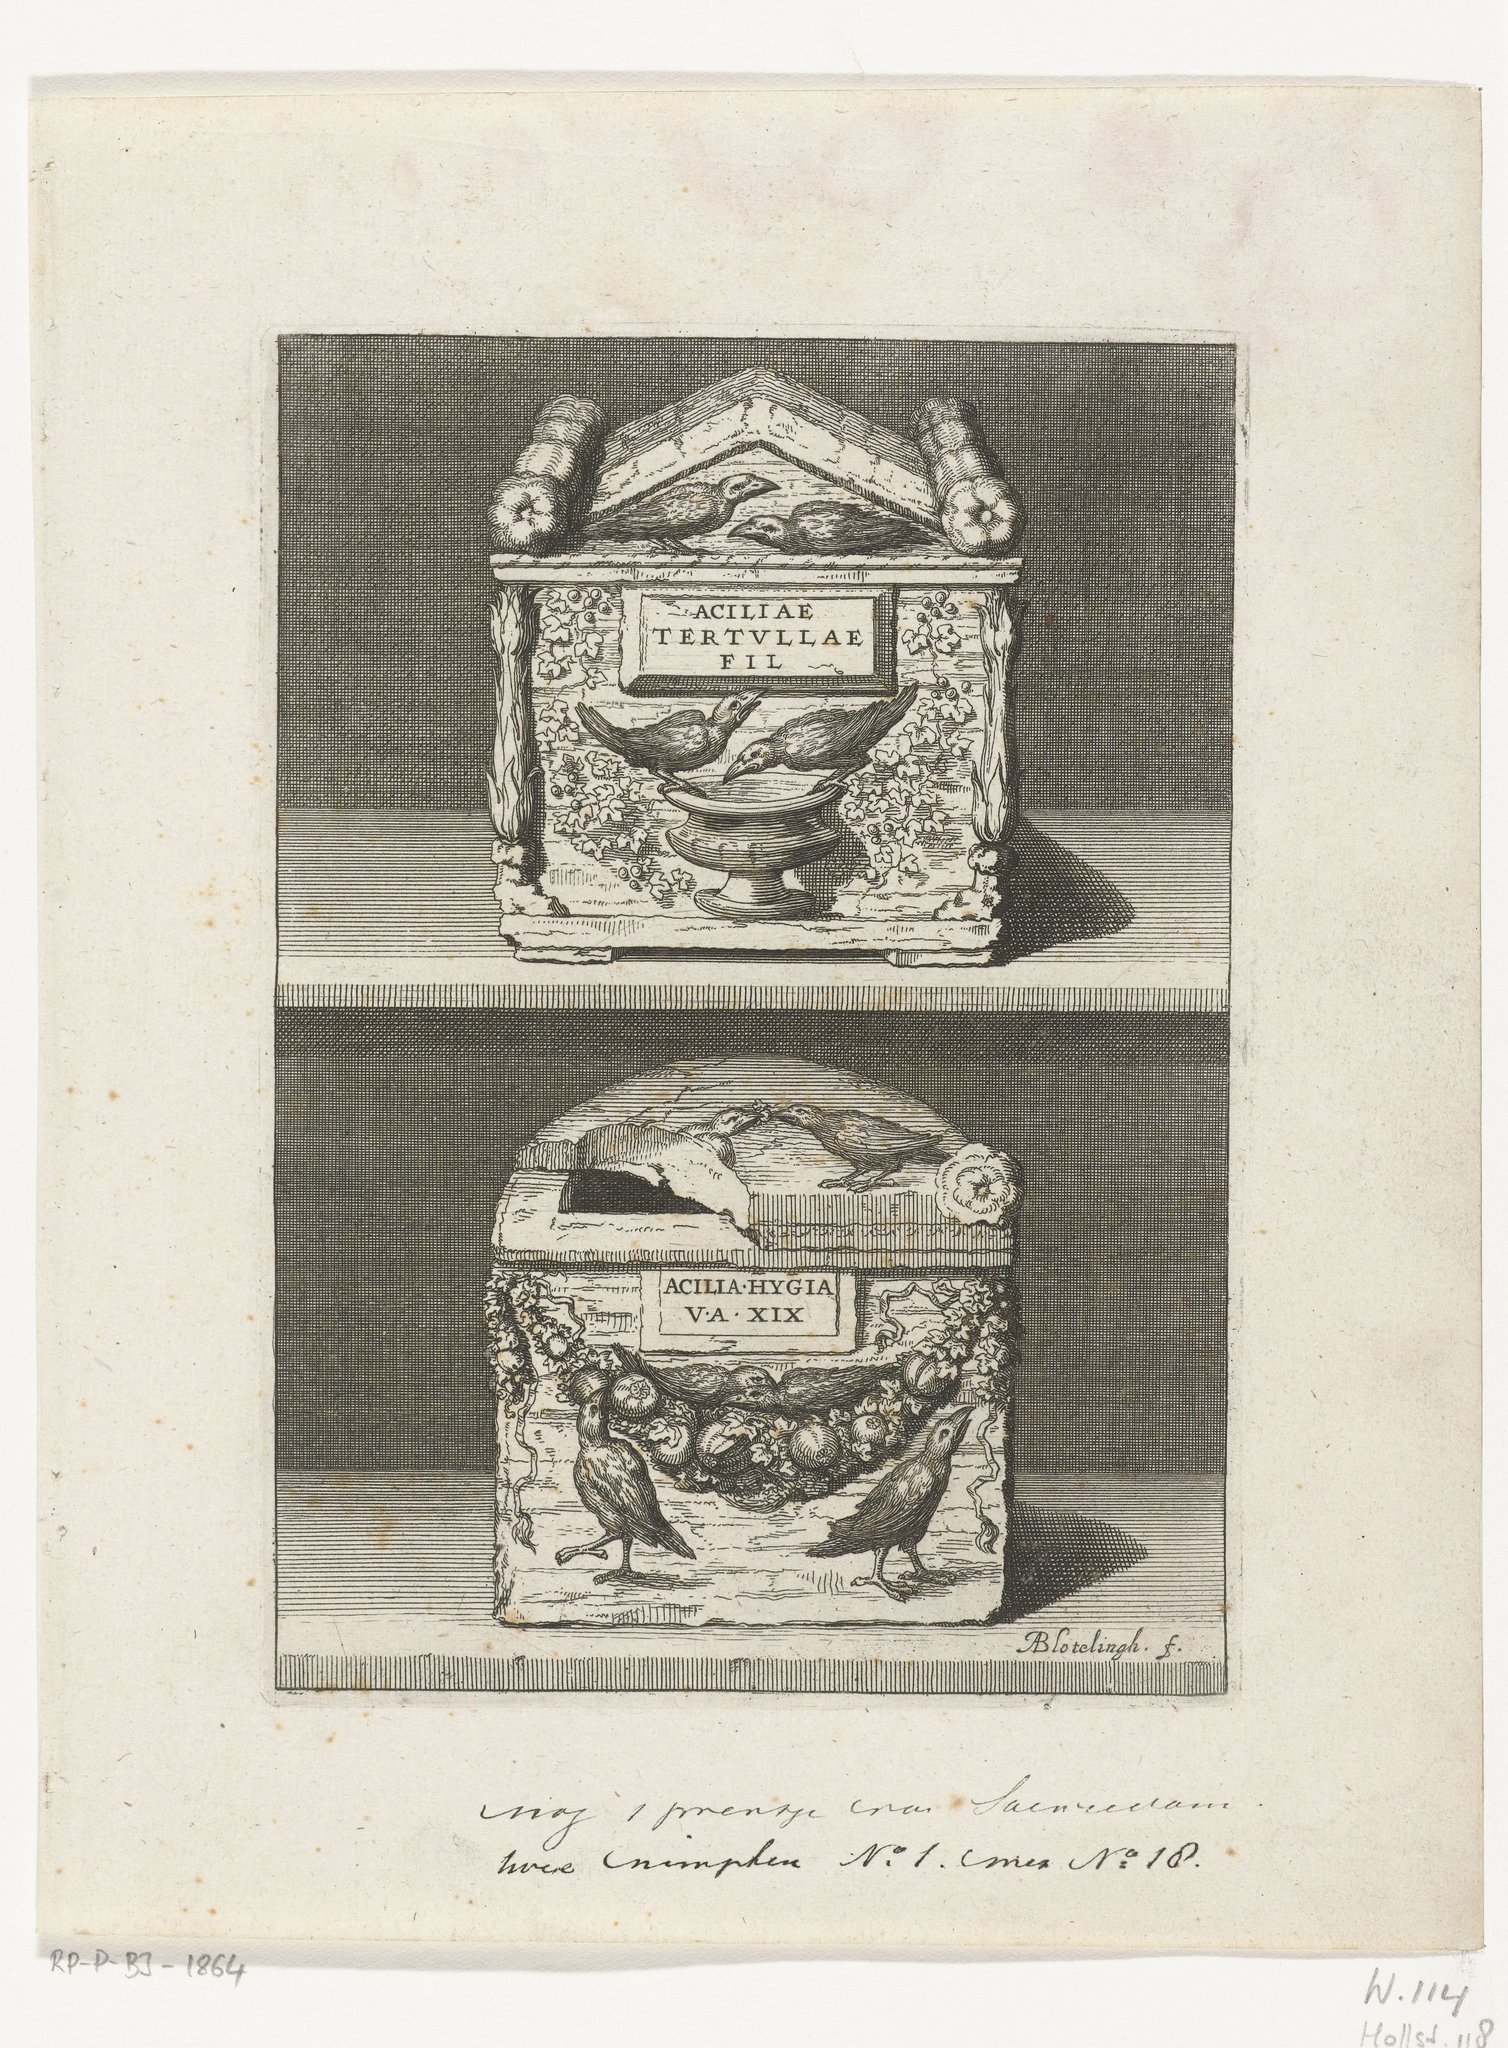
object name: print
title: Twee graftombes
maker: abraham bloteling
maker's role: draughtsman, print maker, publisher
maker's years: 1640-1690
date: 1655-1690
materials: paper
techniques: etching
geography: amsterdam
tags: grave, tomb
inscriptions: collector's mark: Lugt 2228, inscription: ‘nog 1 prentje van Saenredam. / twee nimphen No. 1 met No. 18.’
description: Twee antieke stenen graftombes met vogel- en bloemdecoraties. De deksel van de onderste tombe is beschadigd.